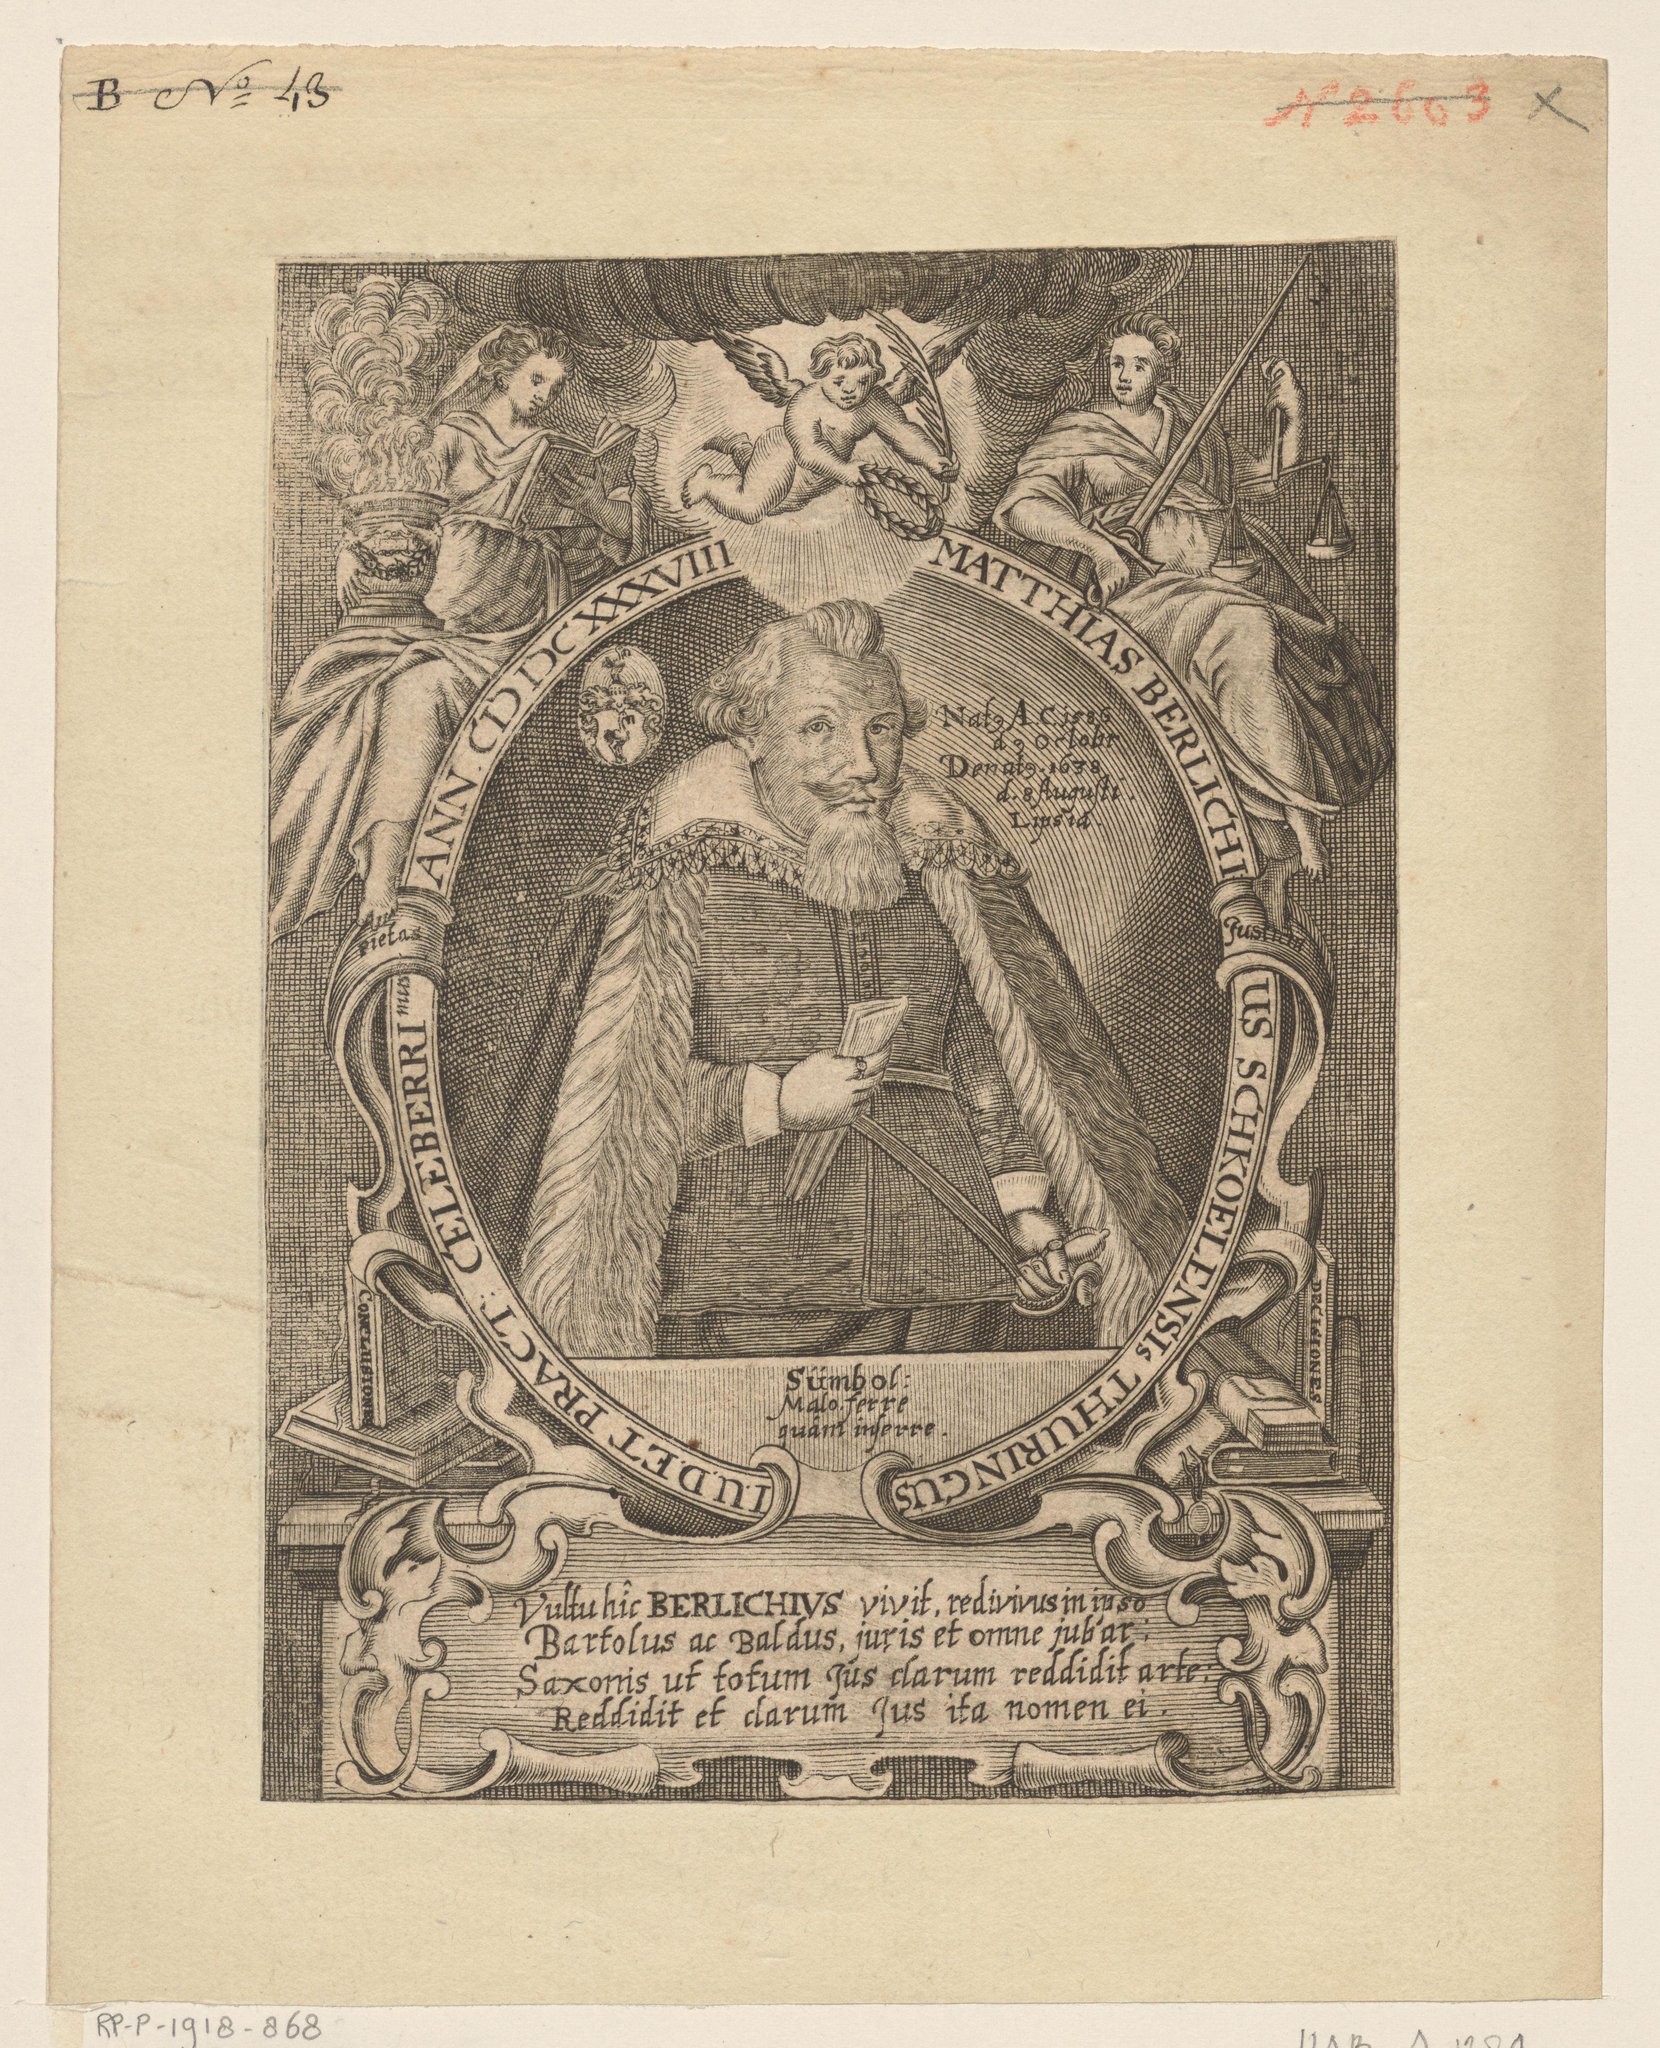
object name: print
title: Portret van Matthias Berlich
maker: Anonymous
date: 1638-1699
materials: paper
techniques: engraving, etching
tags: historical persons, armorial bearing, heraldry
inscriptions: inscription: ‘No. 43 Matthias Berlich, celebre jurisconsulte de Saxe [...]’, collector's mark: Lugt 2233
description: Met links naast het hoofd zijn wapenschild.